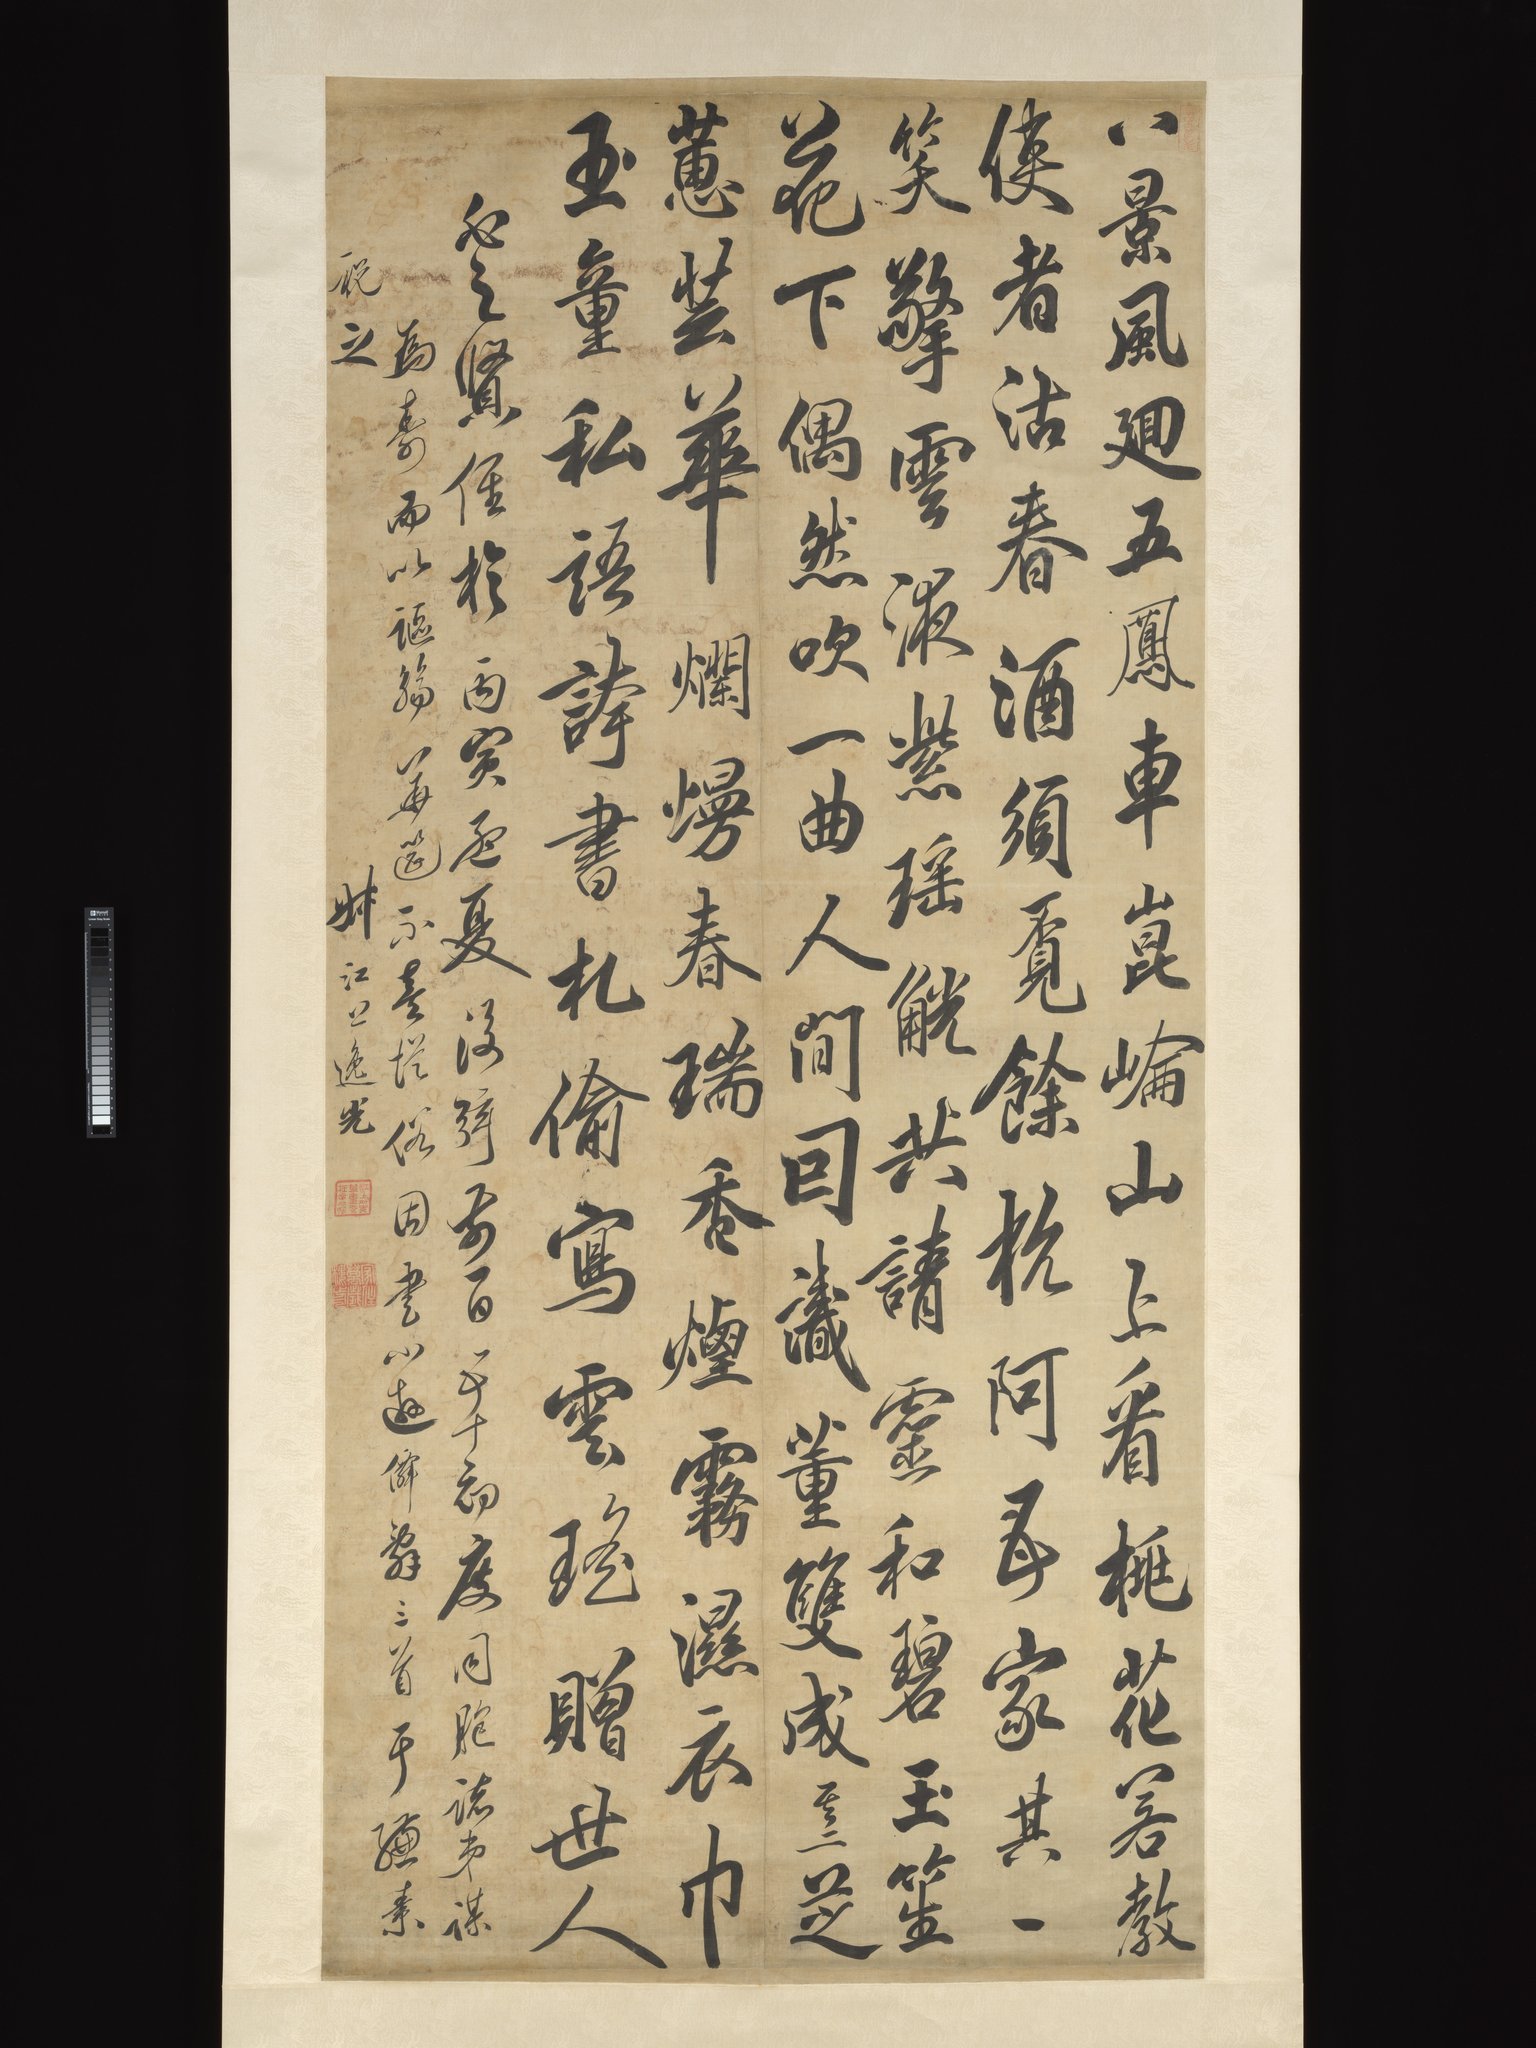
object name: hanging scroll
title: Transcription of Three of Cao Tang’s “Smaller Wandering Immortal Poems”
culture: chinese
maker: da chongguang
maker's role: artist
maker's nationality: chinese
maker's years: 1623-1692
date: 1686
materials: ink, textile